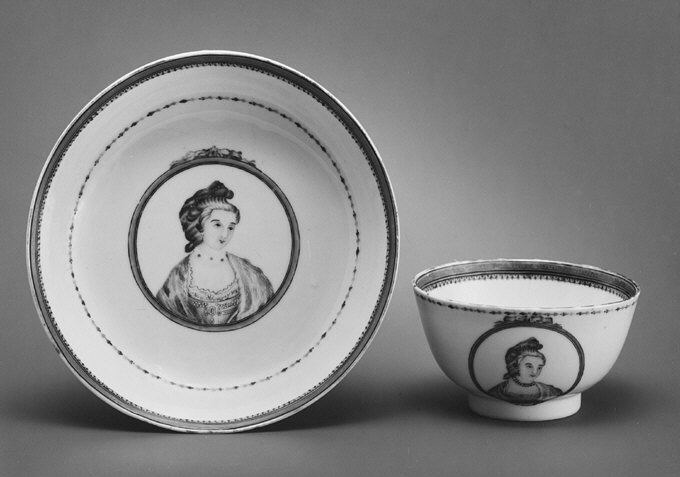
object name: teabowl and saucer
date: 1780-1790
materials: hard paste porcelain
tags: portraits,women